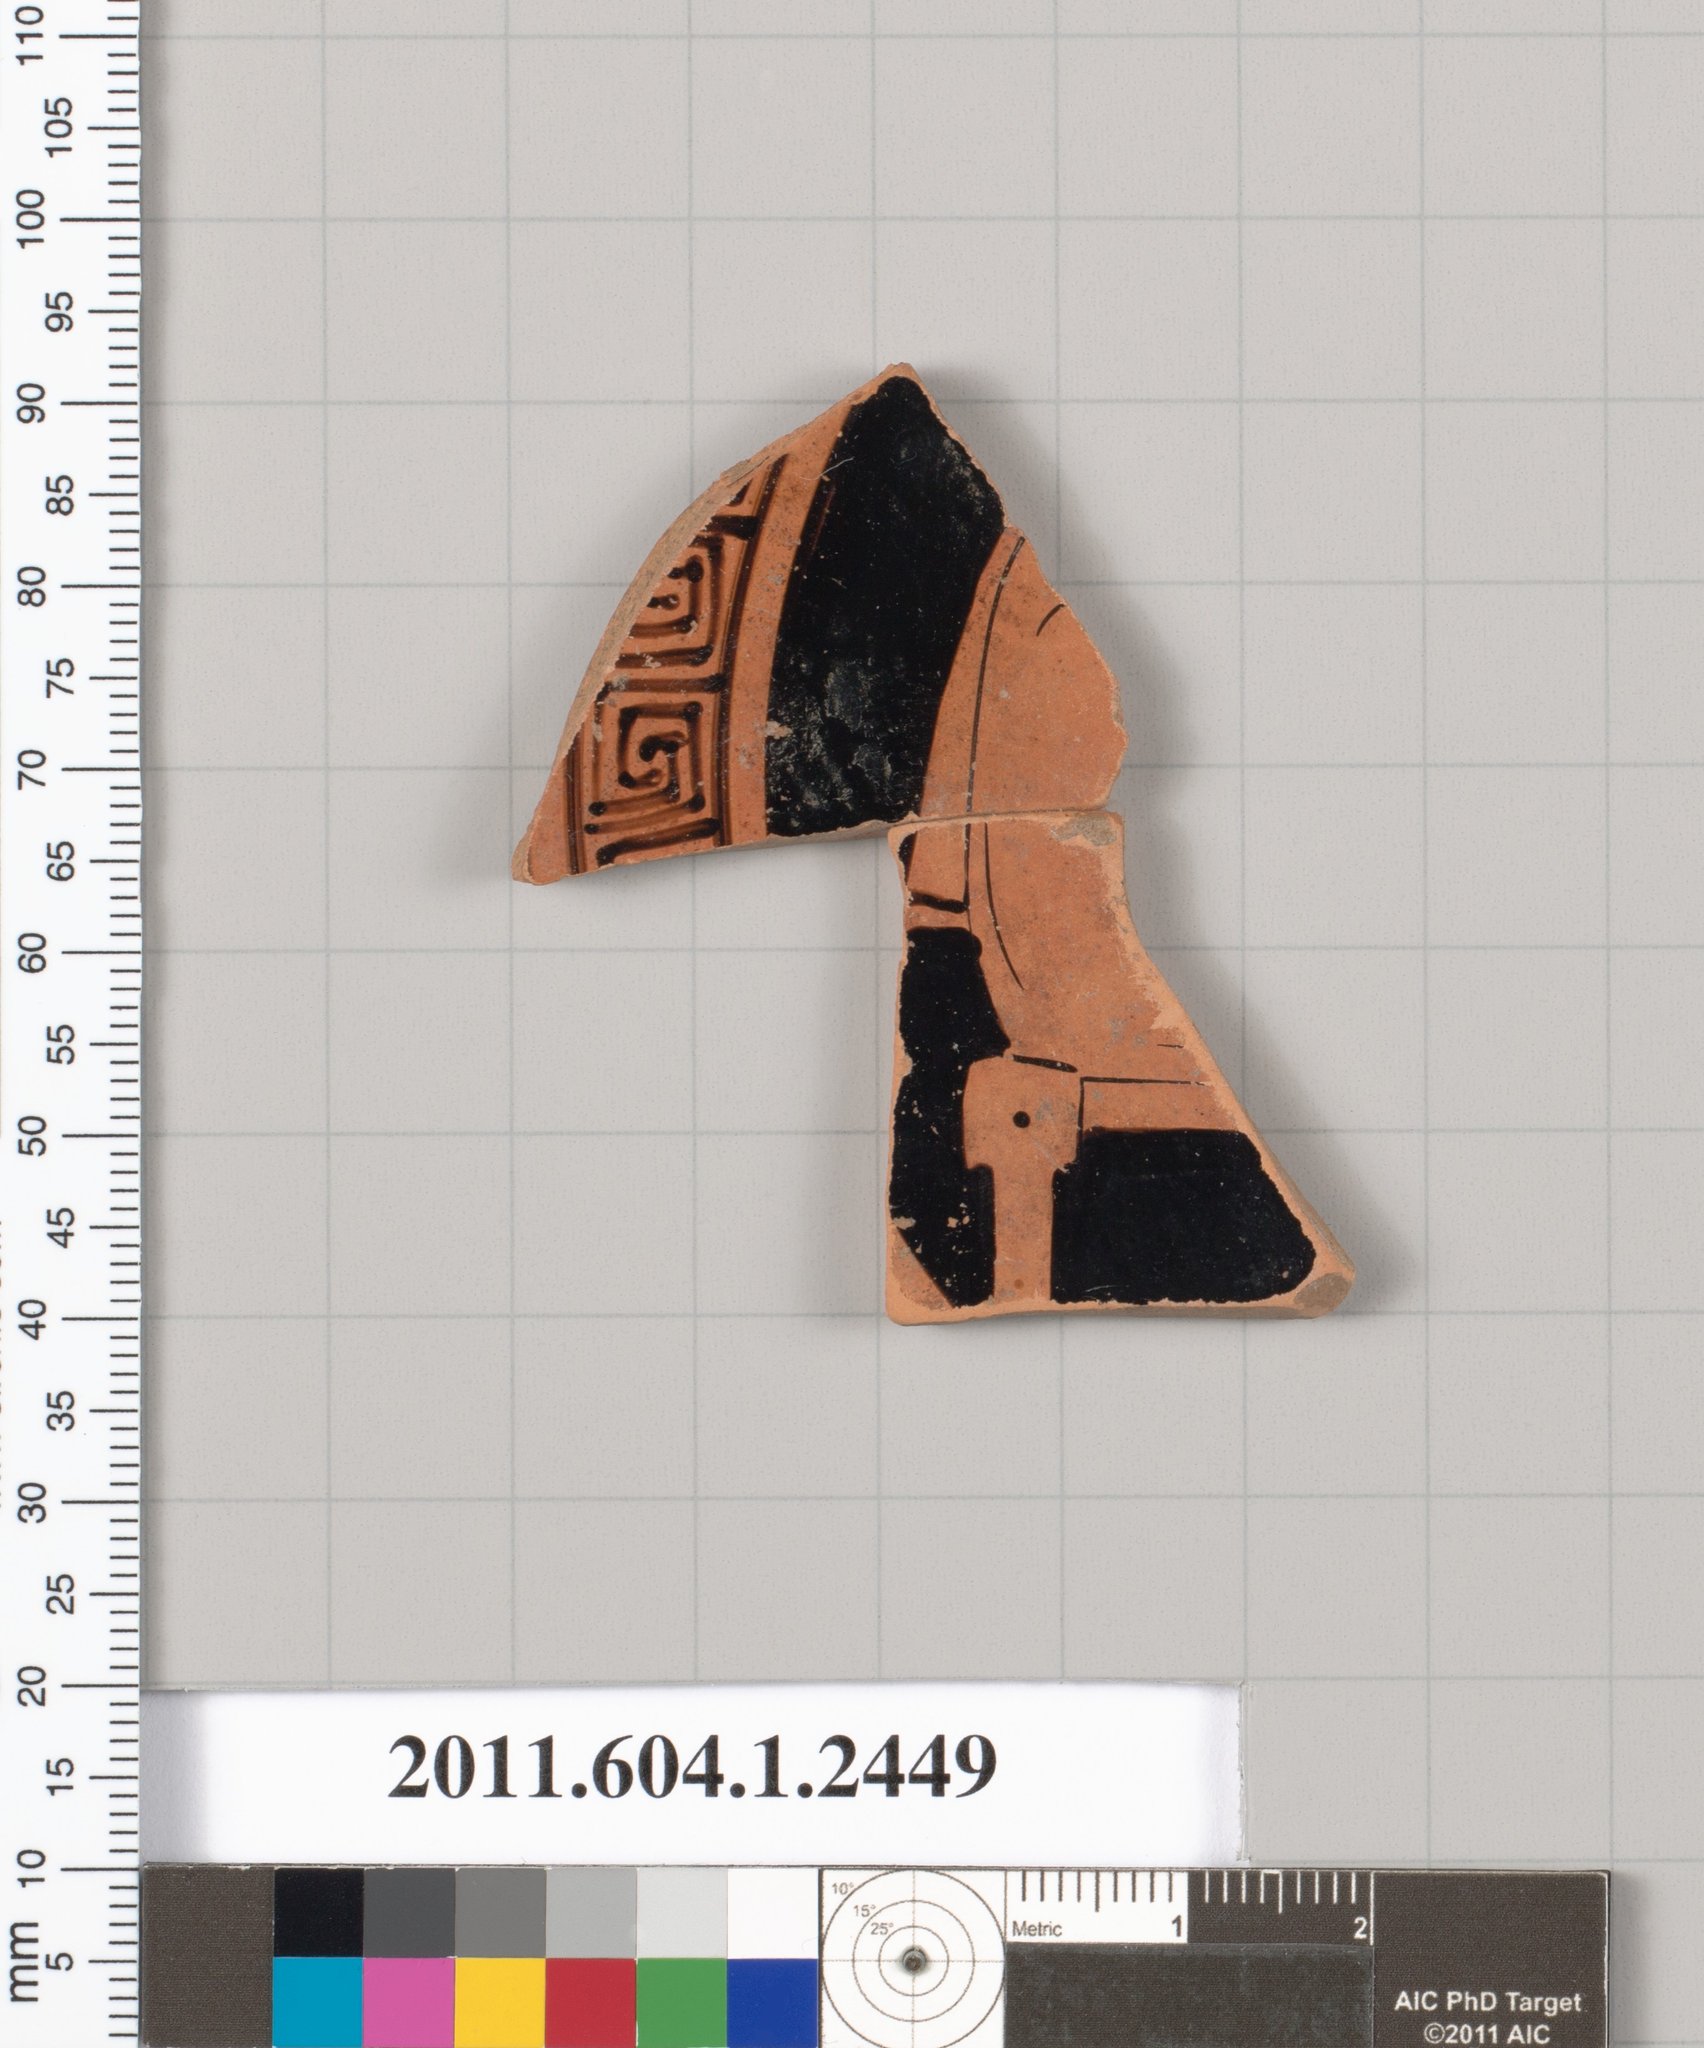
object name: kylix fragment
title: Terracotta fragment of a kylix (drinking cup)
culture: greek, attic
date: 475-451 BCE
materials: terracotta